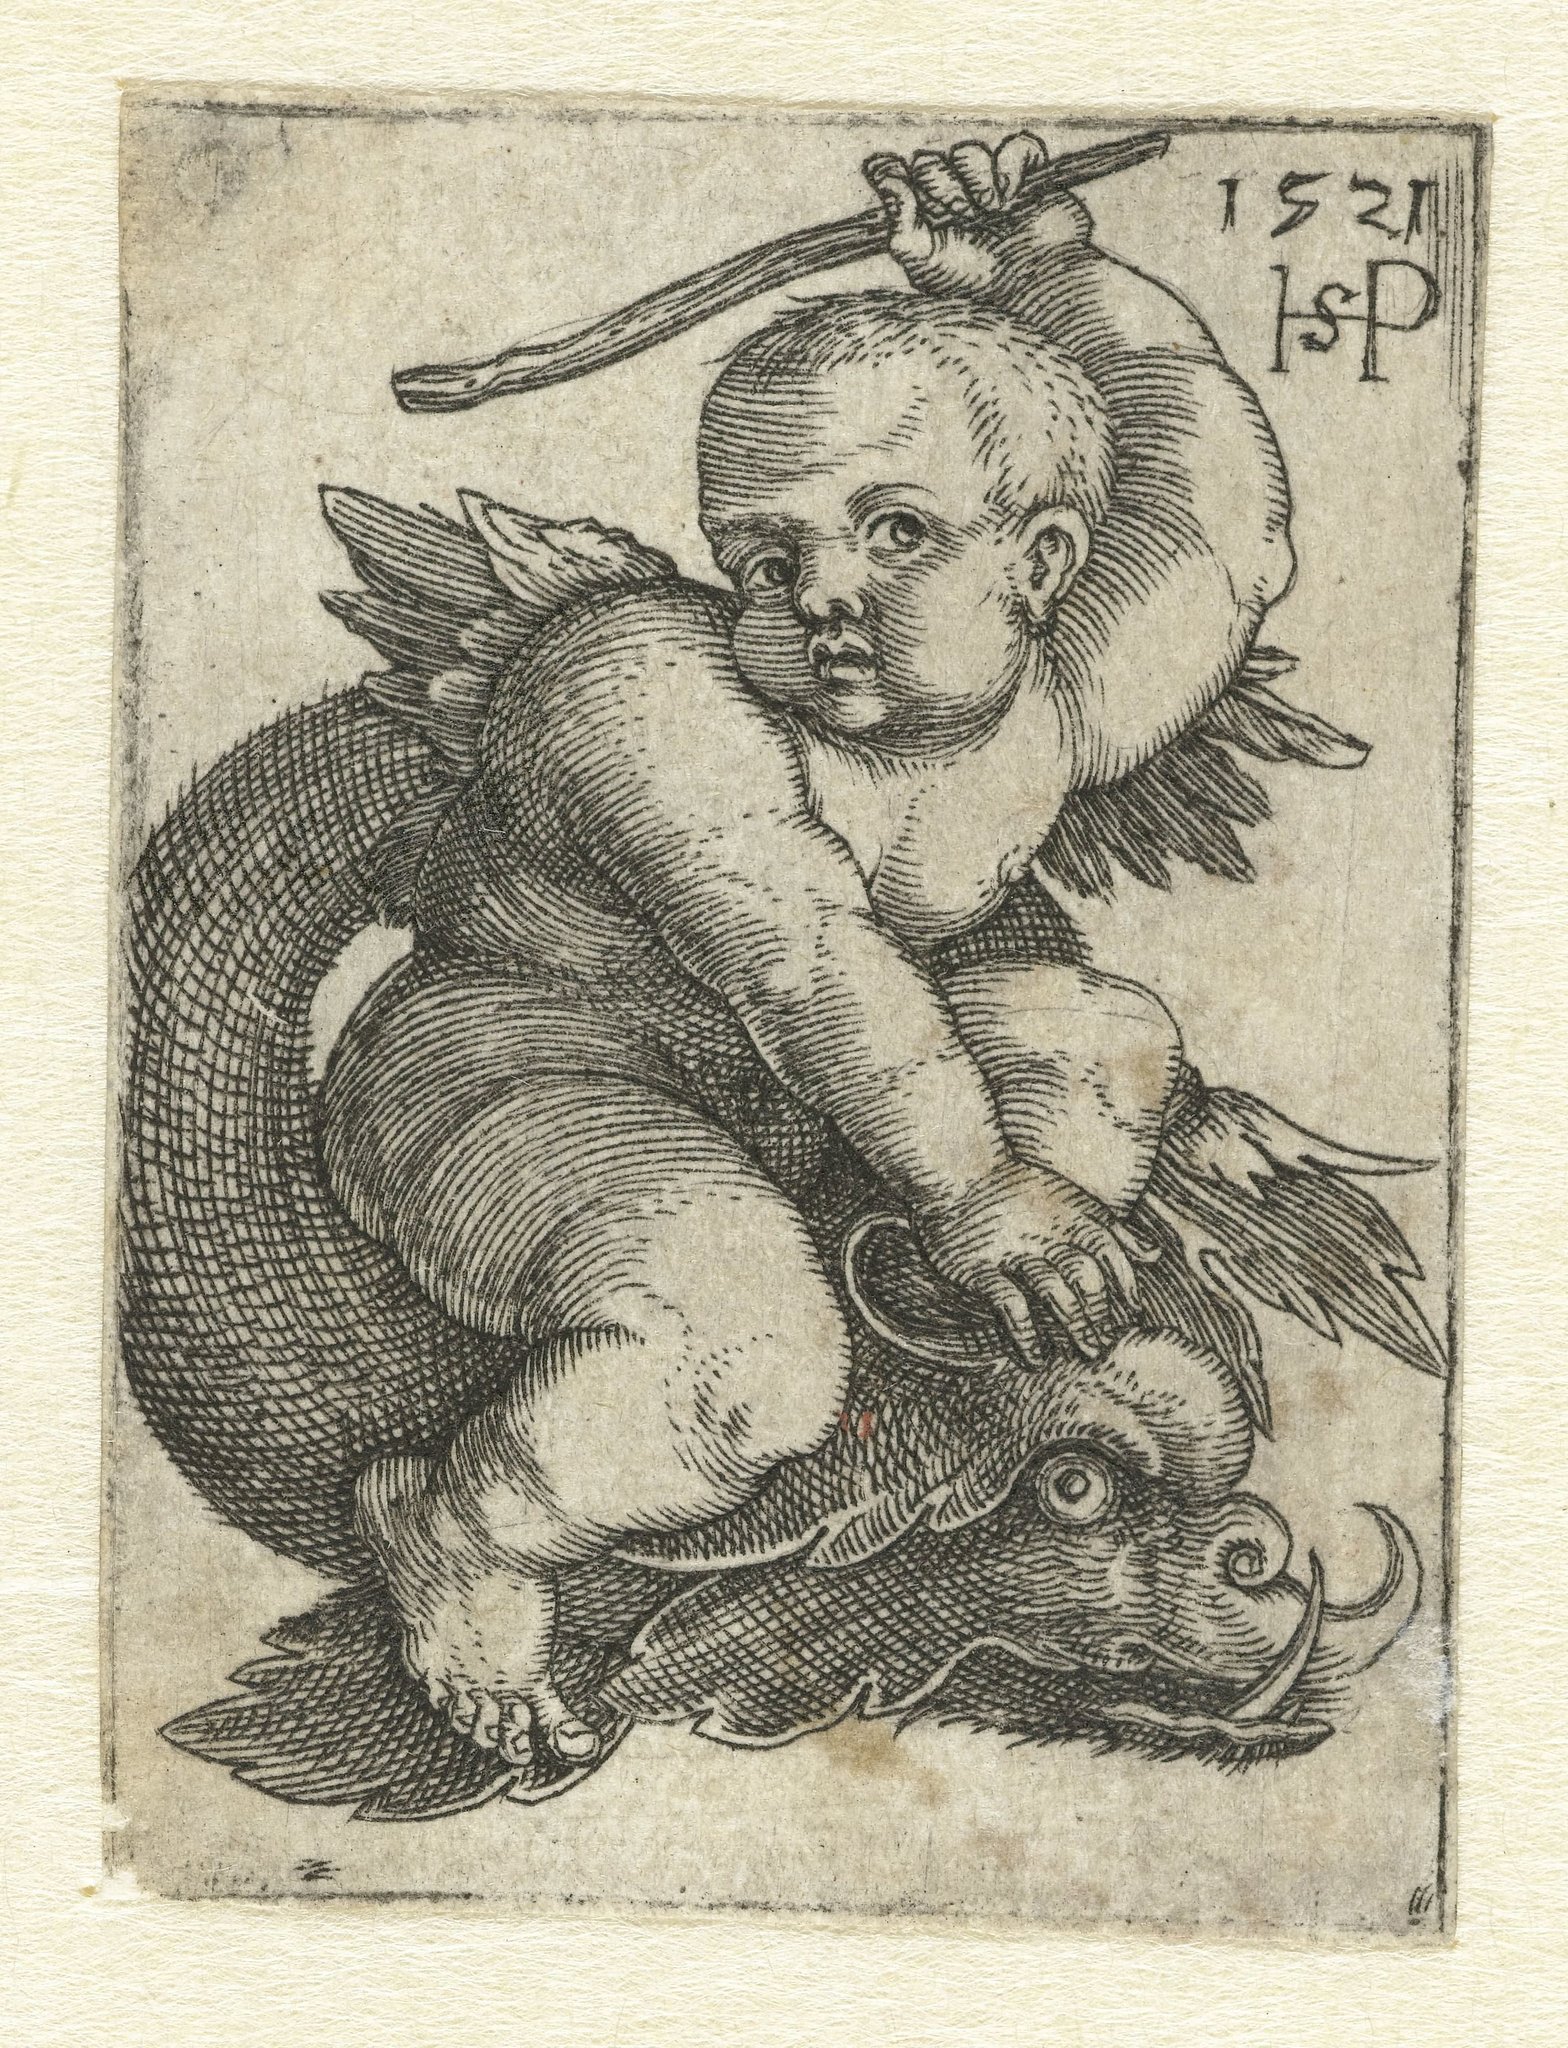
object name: print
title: Putto op een dolfijn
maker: hans sebald beham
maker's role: designer, draughtsman, print maker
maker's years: 1500-1550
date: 1521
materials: paper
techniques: engraving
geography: nuremberg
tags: swimming mammals: dolphin, cupids: 'amores', 'amoretti', 'putti'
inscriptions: collector's mark: Lugt 240